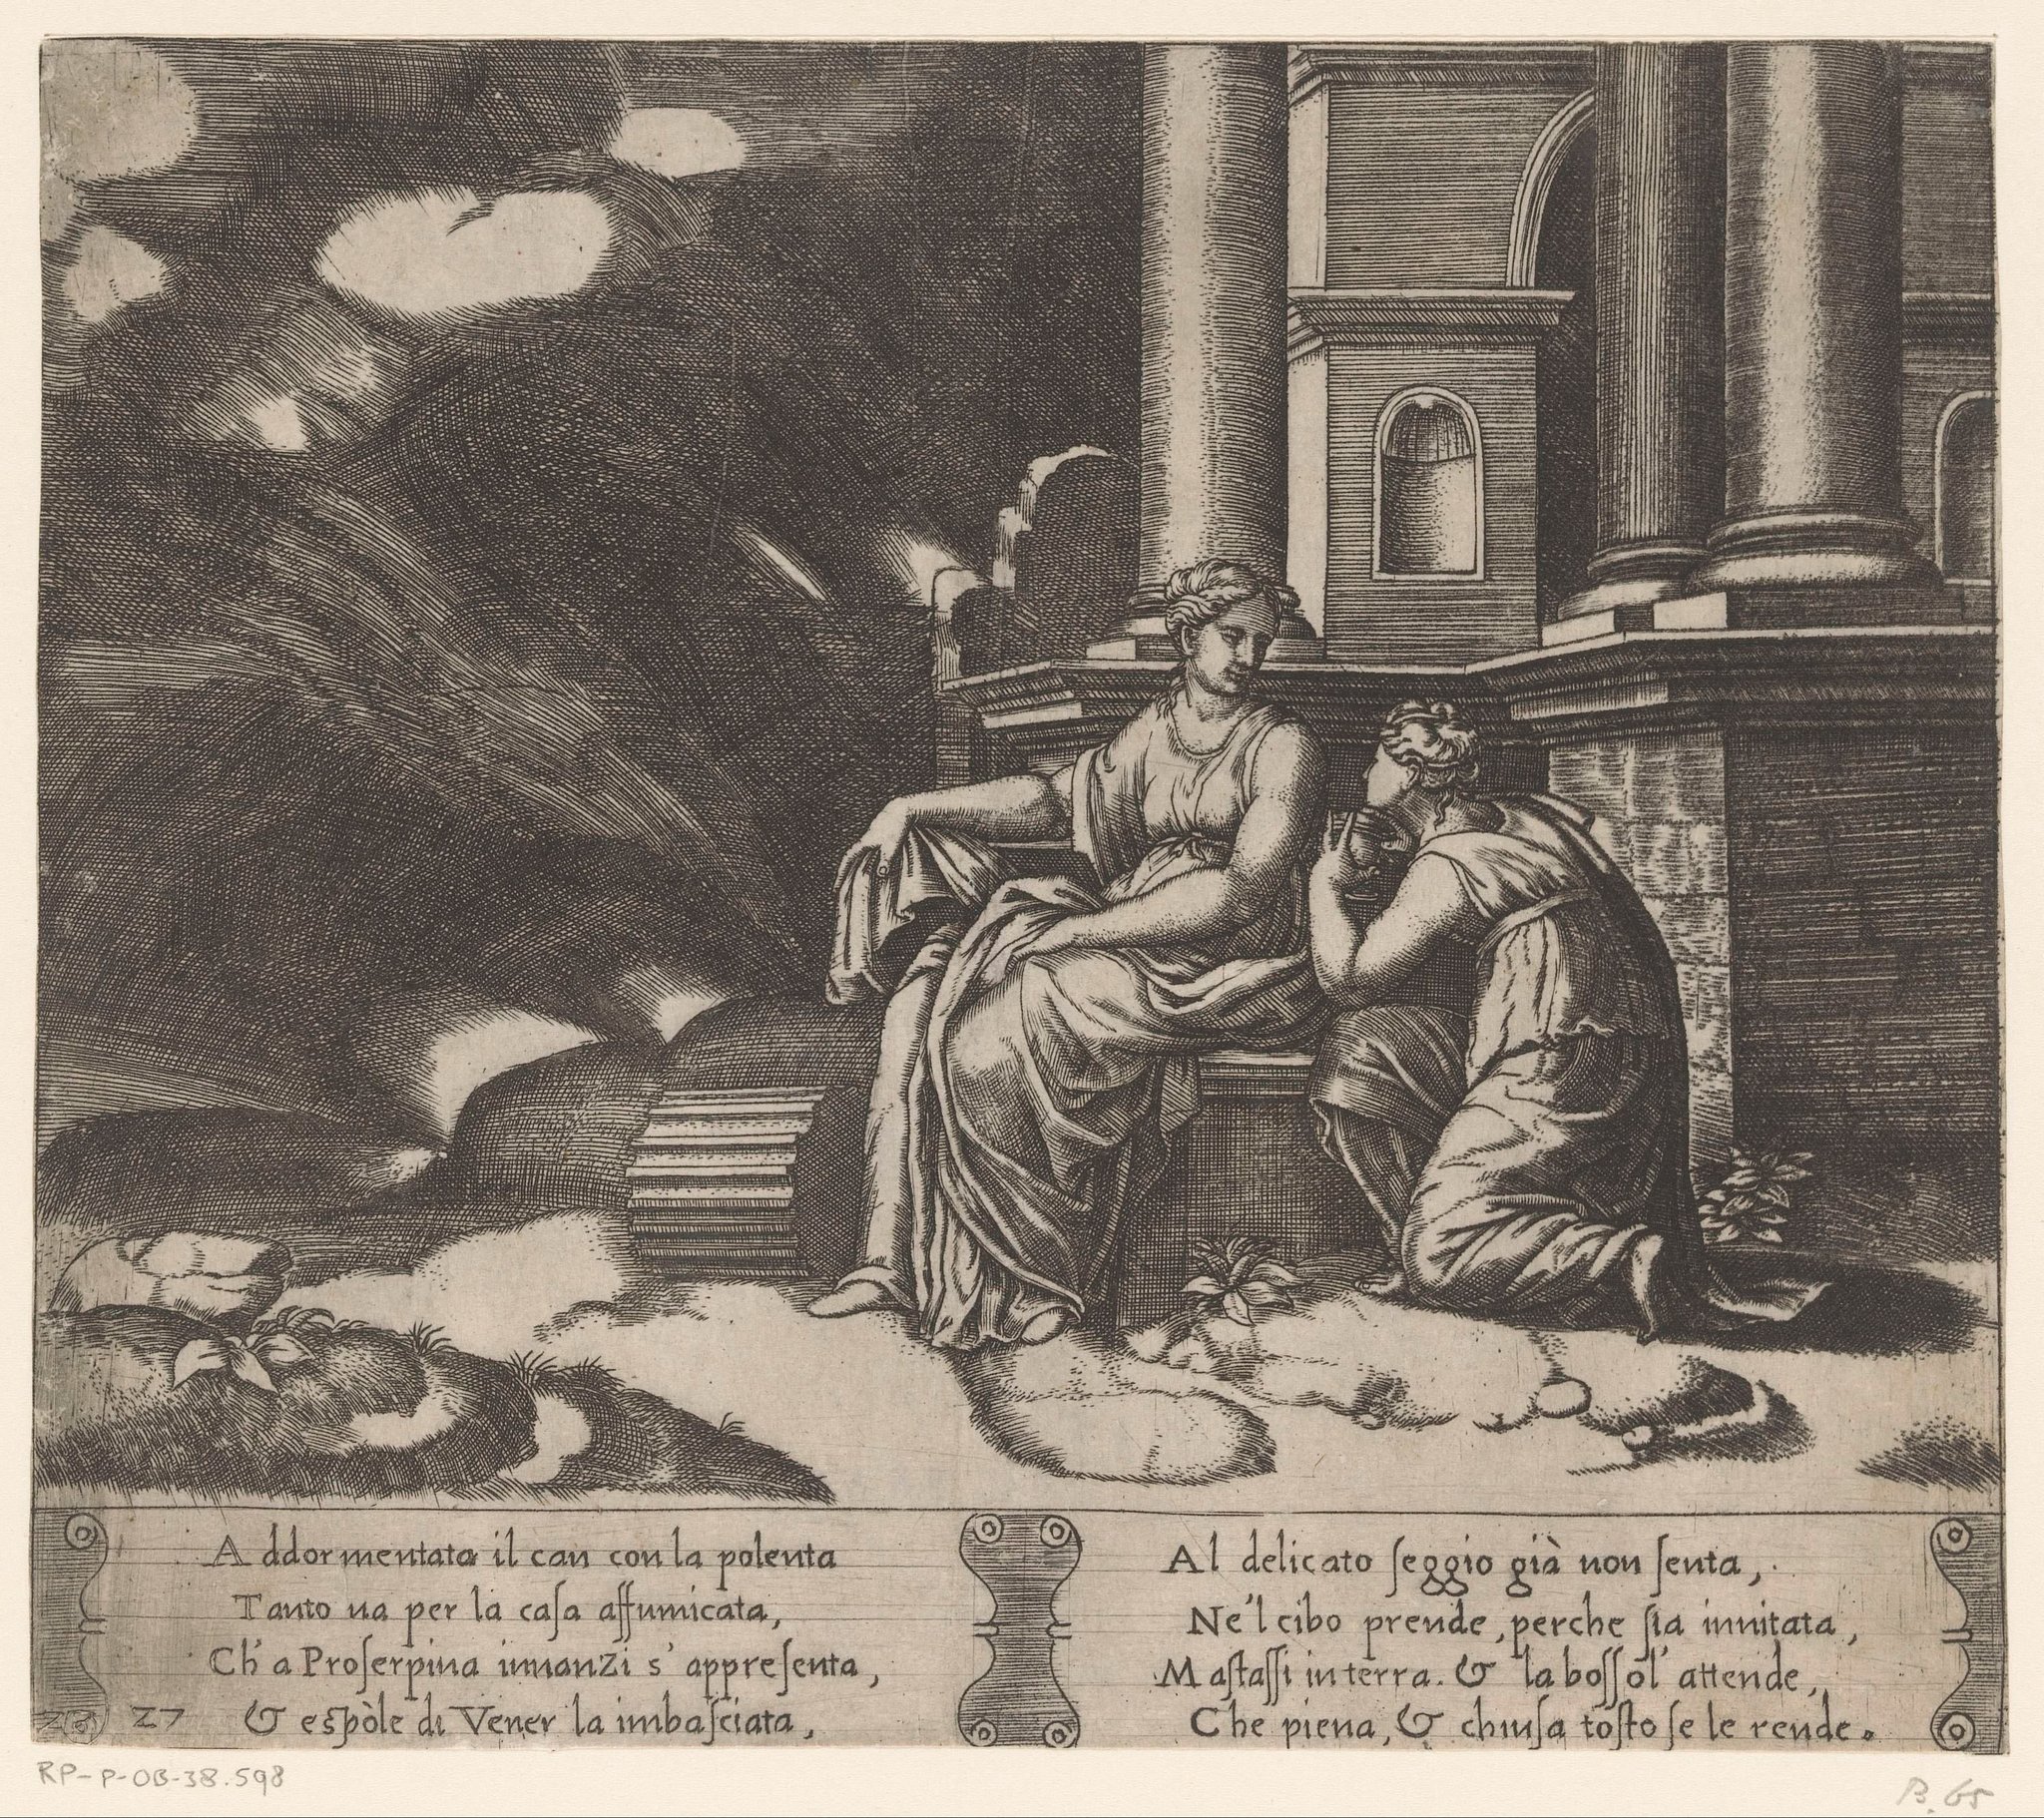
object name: print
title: Verhaal van Amor en Psyche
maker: meester van de dobbelsteen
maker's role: print maker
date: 1530-1560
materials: paper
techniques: engraving, intaglio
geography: italy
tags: psyche before proserpina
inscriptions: collector's mark: Lugt 2228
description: In de onderwereld neemt Psyche de kruik in ontvangst gevuld met de schoonheid van Proserpina, de koningin van onderwereld. Italiaanse tekst in twee cartouches in ondermarge. Tweemaal genummerd linksonder: 27.